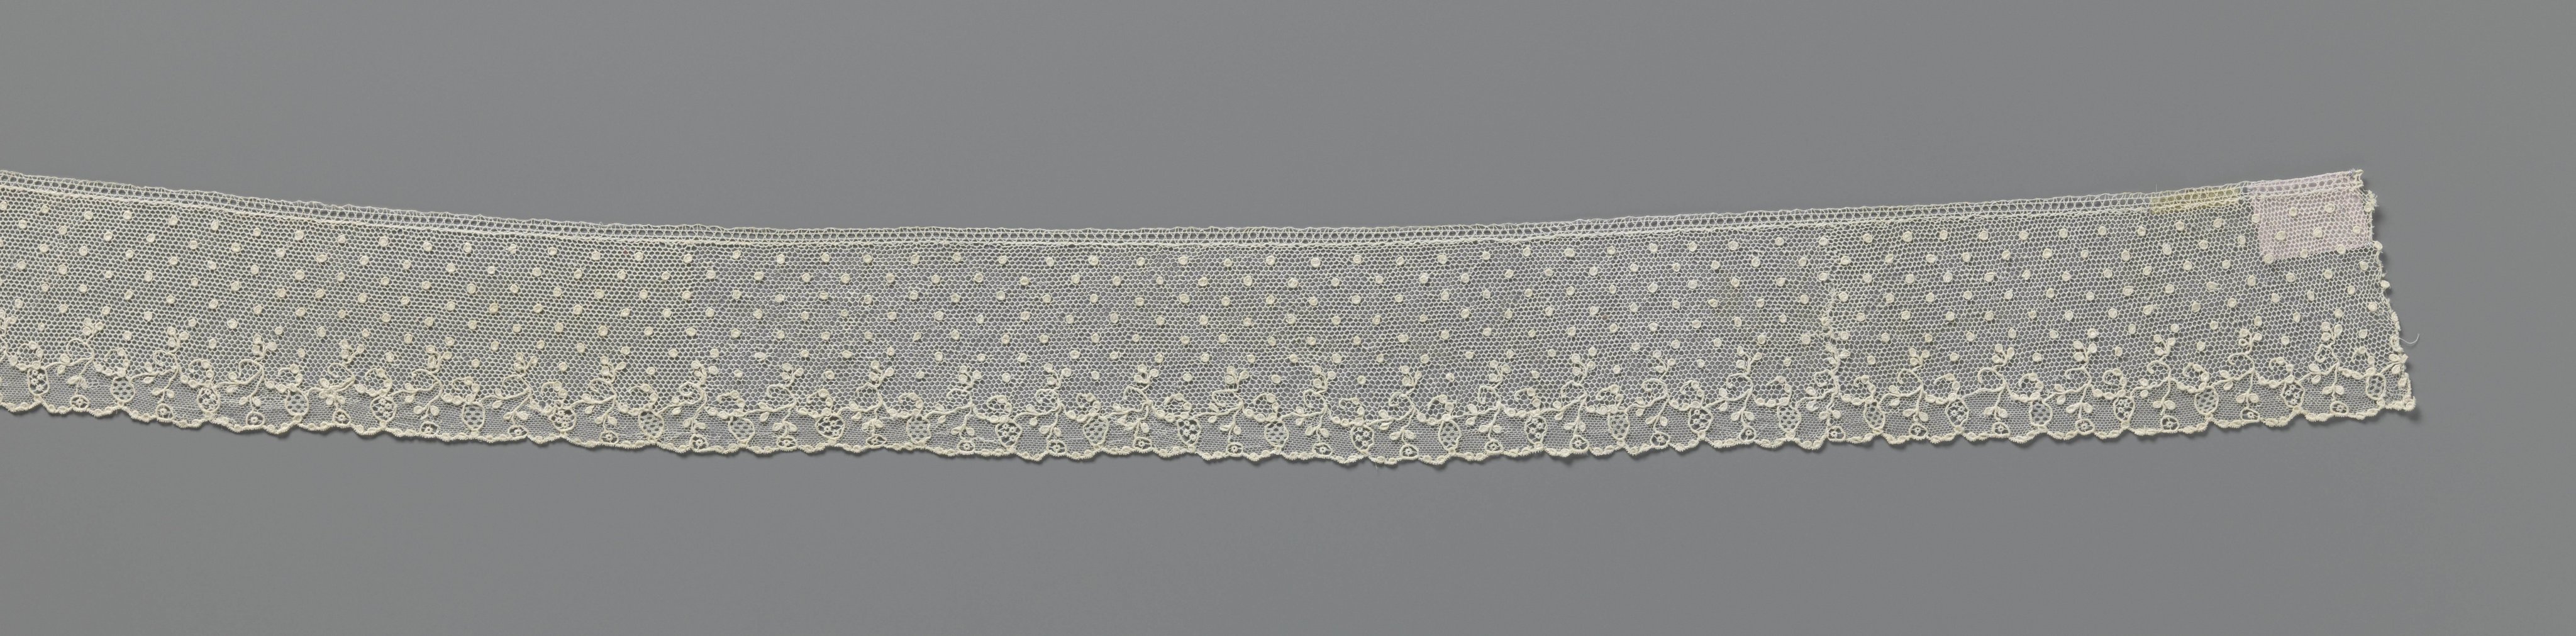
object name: strip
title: Strook naaldkant met stippen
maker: Anonymous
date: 1750-1799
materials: linen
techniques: lace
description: Strook naturelkleurige naaldkant: Alençon-kant. Regelmatig patroon van stippen, die gevormd worden door cirkelvormige moesjes met kordon, op een fijne zeshoekige maasgrond. Het patroon aan de onderzijde bestaat uit één fijn rond bloempje met raderpicot in het hart afgewisseld met ovaaltjes. De steeltjes van de bloempjes wijzen verticaal omhoog en krullen aan het eind. De ovaaltjes zijn opgevuld met een siergrond, afwisselend met en zonder (rader)picots. De maasgrond tussen de bloempjes en ovaaltjes is fijner dan de maasgrond met stippen erboven. De bovenzijde is afgezet met een rand kloskant. Aan de onderzijde verbindt een boogjesrand de hiervoor beschreven bloempjes en ovaaltjes.